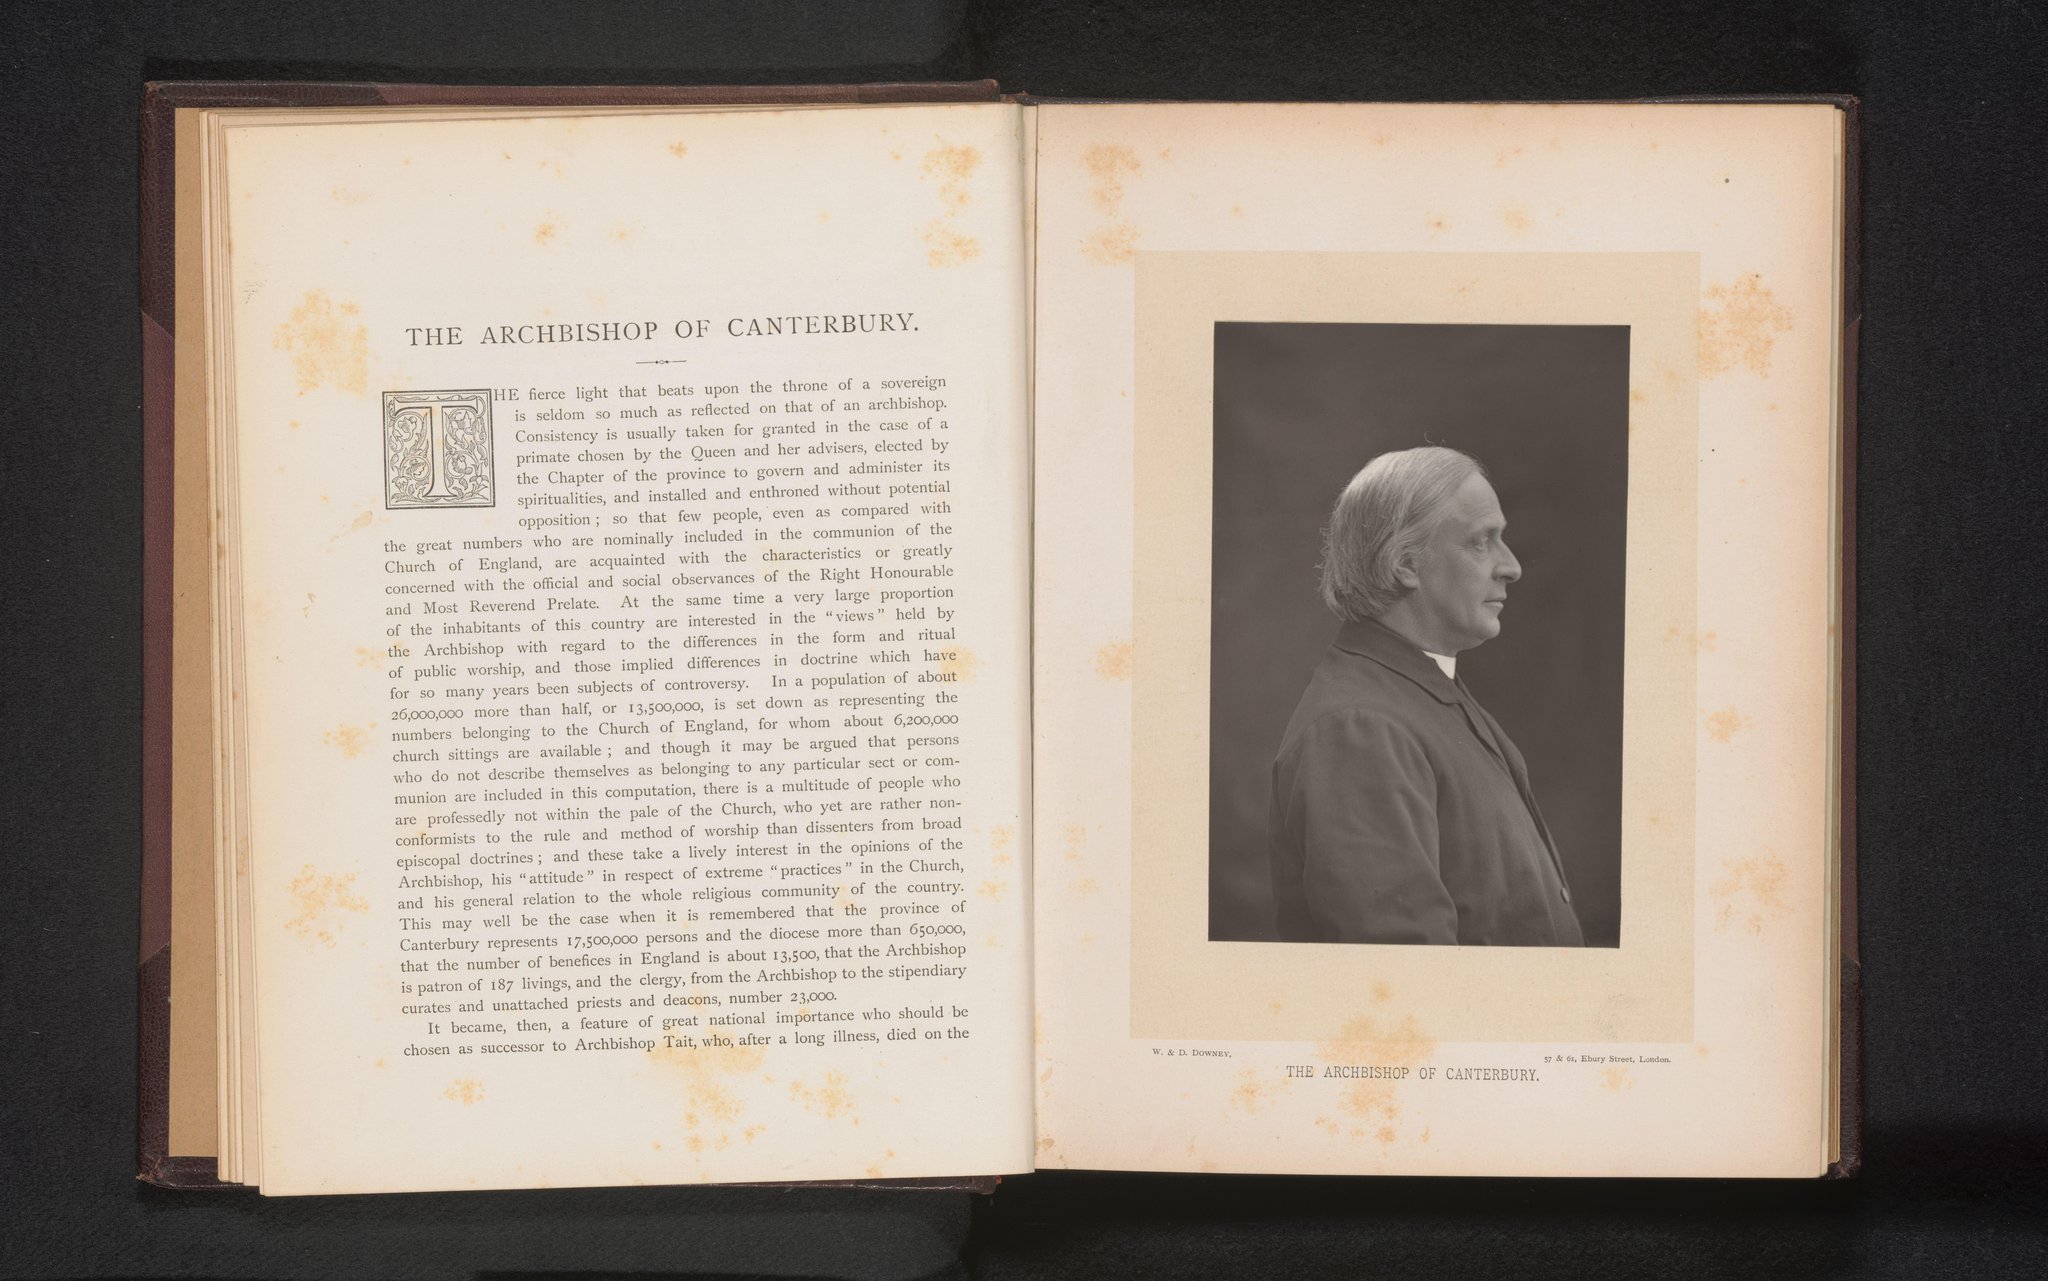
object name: photograph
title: Portret van Edward White Benson, aartsbisschop van Canterbury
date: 1885-1890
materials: paper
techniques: carbon print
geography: london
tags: historical persons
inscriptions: address: ‘57 & 61, Ebury Street, London.’